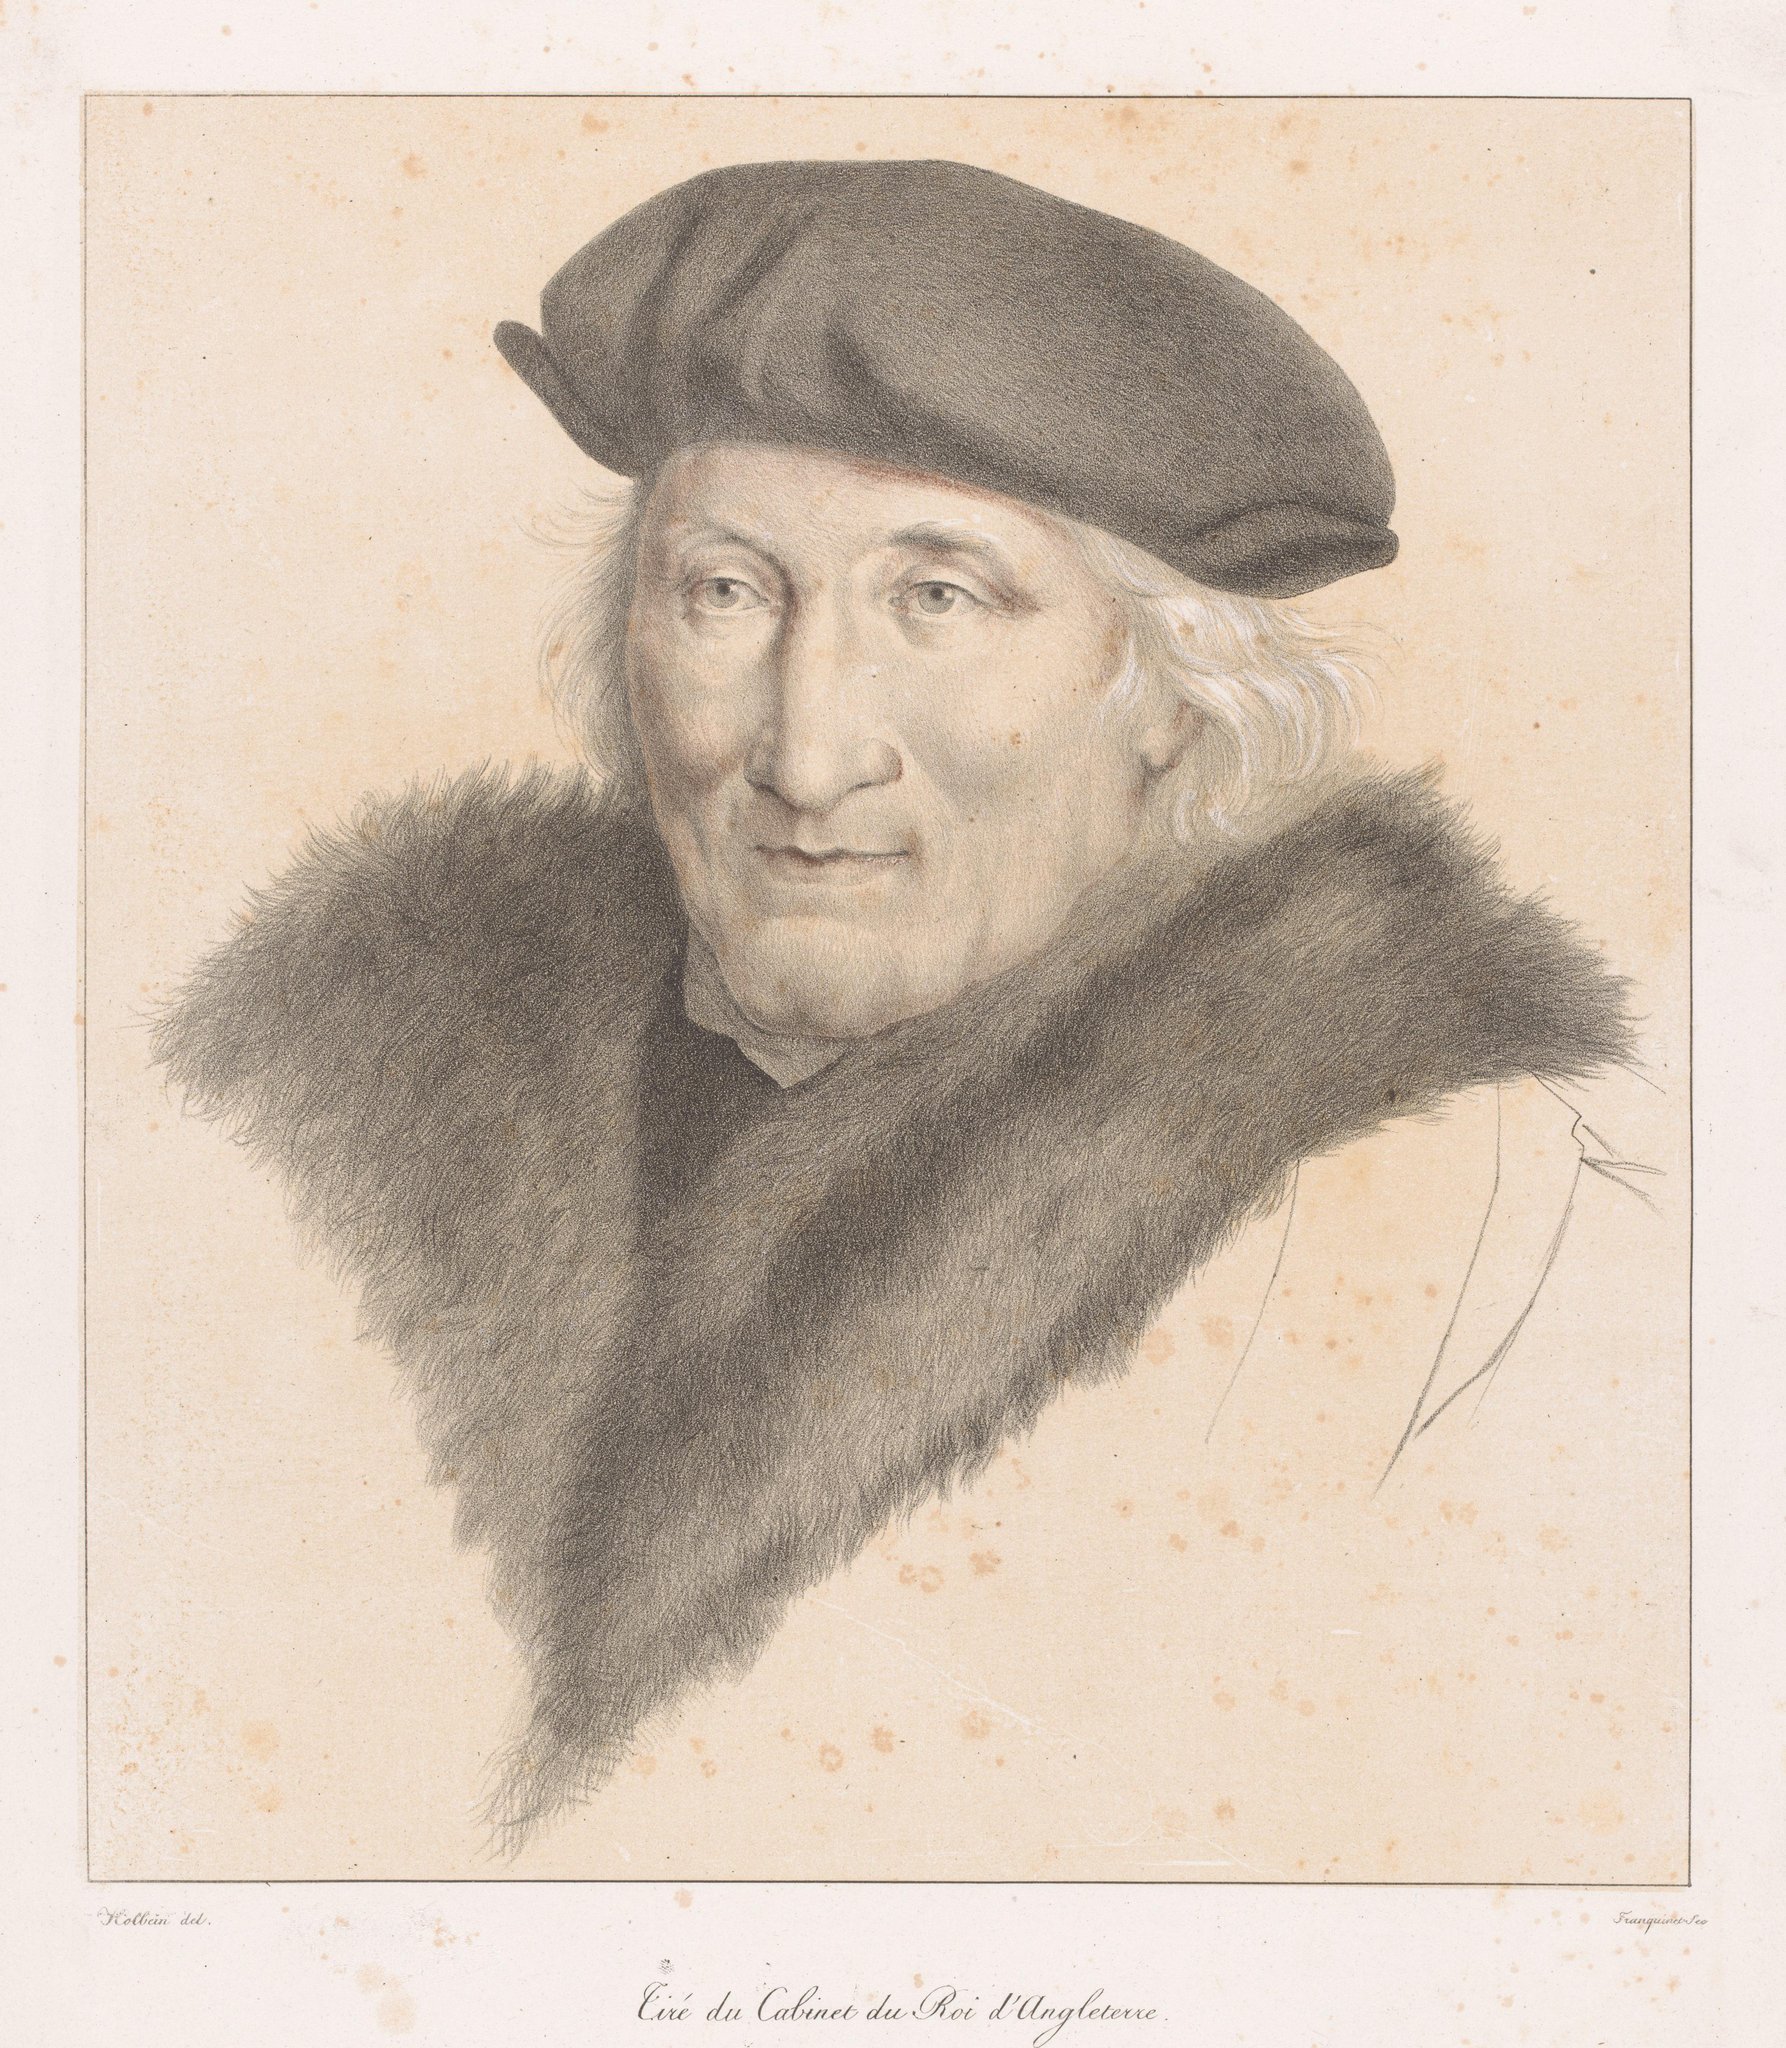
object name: print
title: Portret van John More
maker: willem hendrik franquinet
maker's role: print maker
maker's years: 1785-1854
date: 1809-1854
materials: paper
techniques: tone lithography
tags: neck-gear ~ clothing (fur collar), historical persons (+ (full) bust portrait)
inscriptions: collector's mark: Lugt 2233, collector's mark: Lugt 2228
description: De geportretteerde draagt een baret en een brede bontkraag. Naar een tekening door Hans Holbein, circa 1527, in de Engelse Koninklijke collectie.